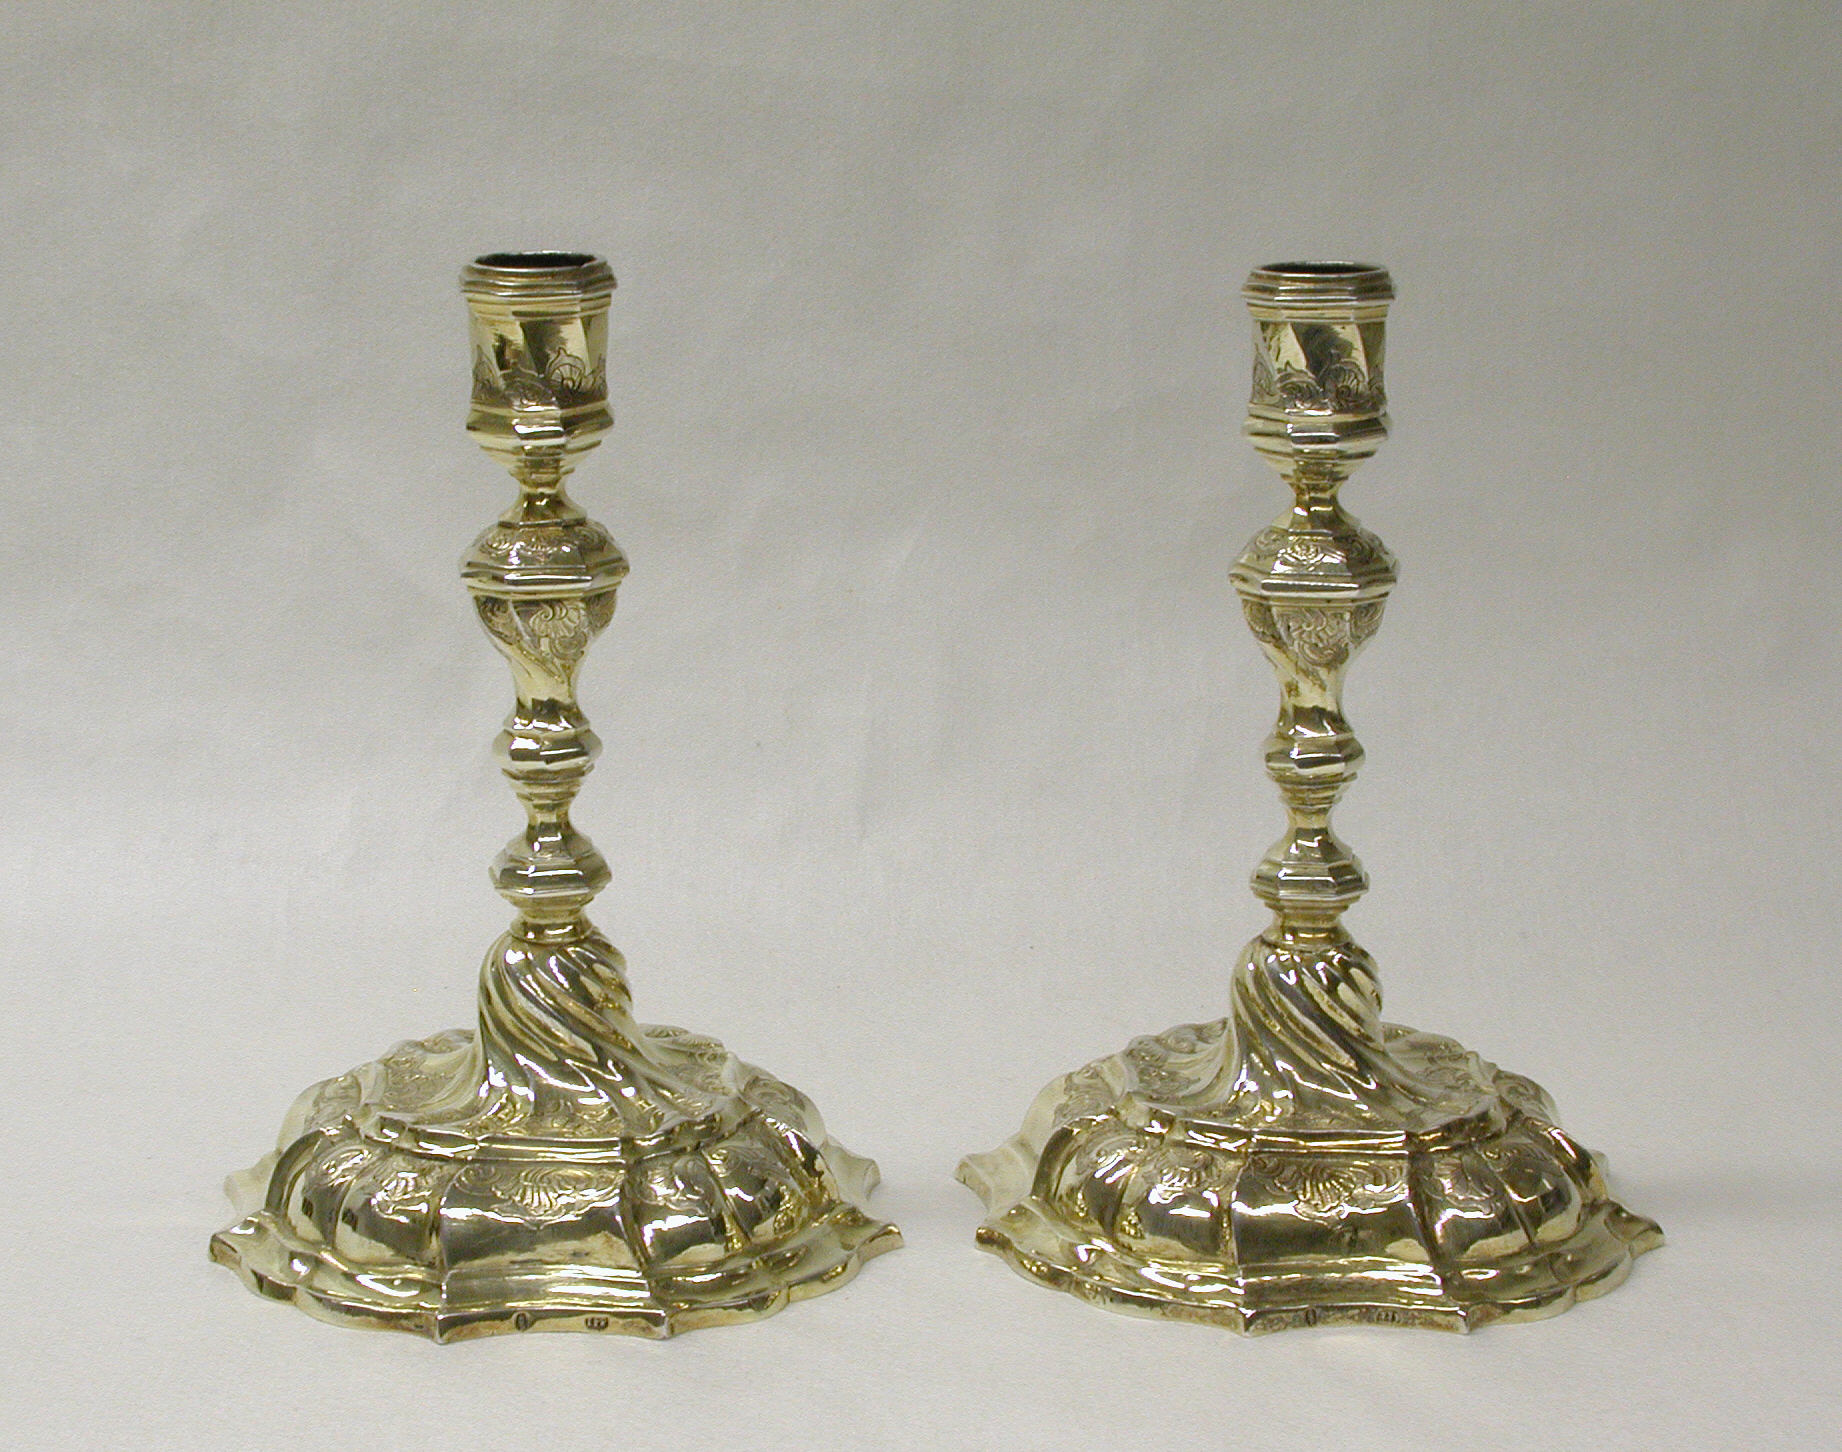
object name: candlestick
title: Candlestick (one of a pair)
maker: johann peter pepfenhauser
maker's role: maker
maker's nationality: german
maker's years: 1738-1747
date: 1743-1745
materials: silver gilt